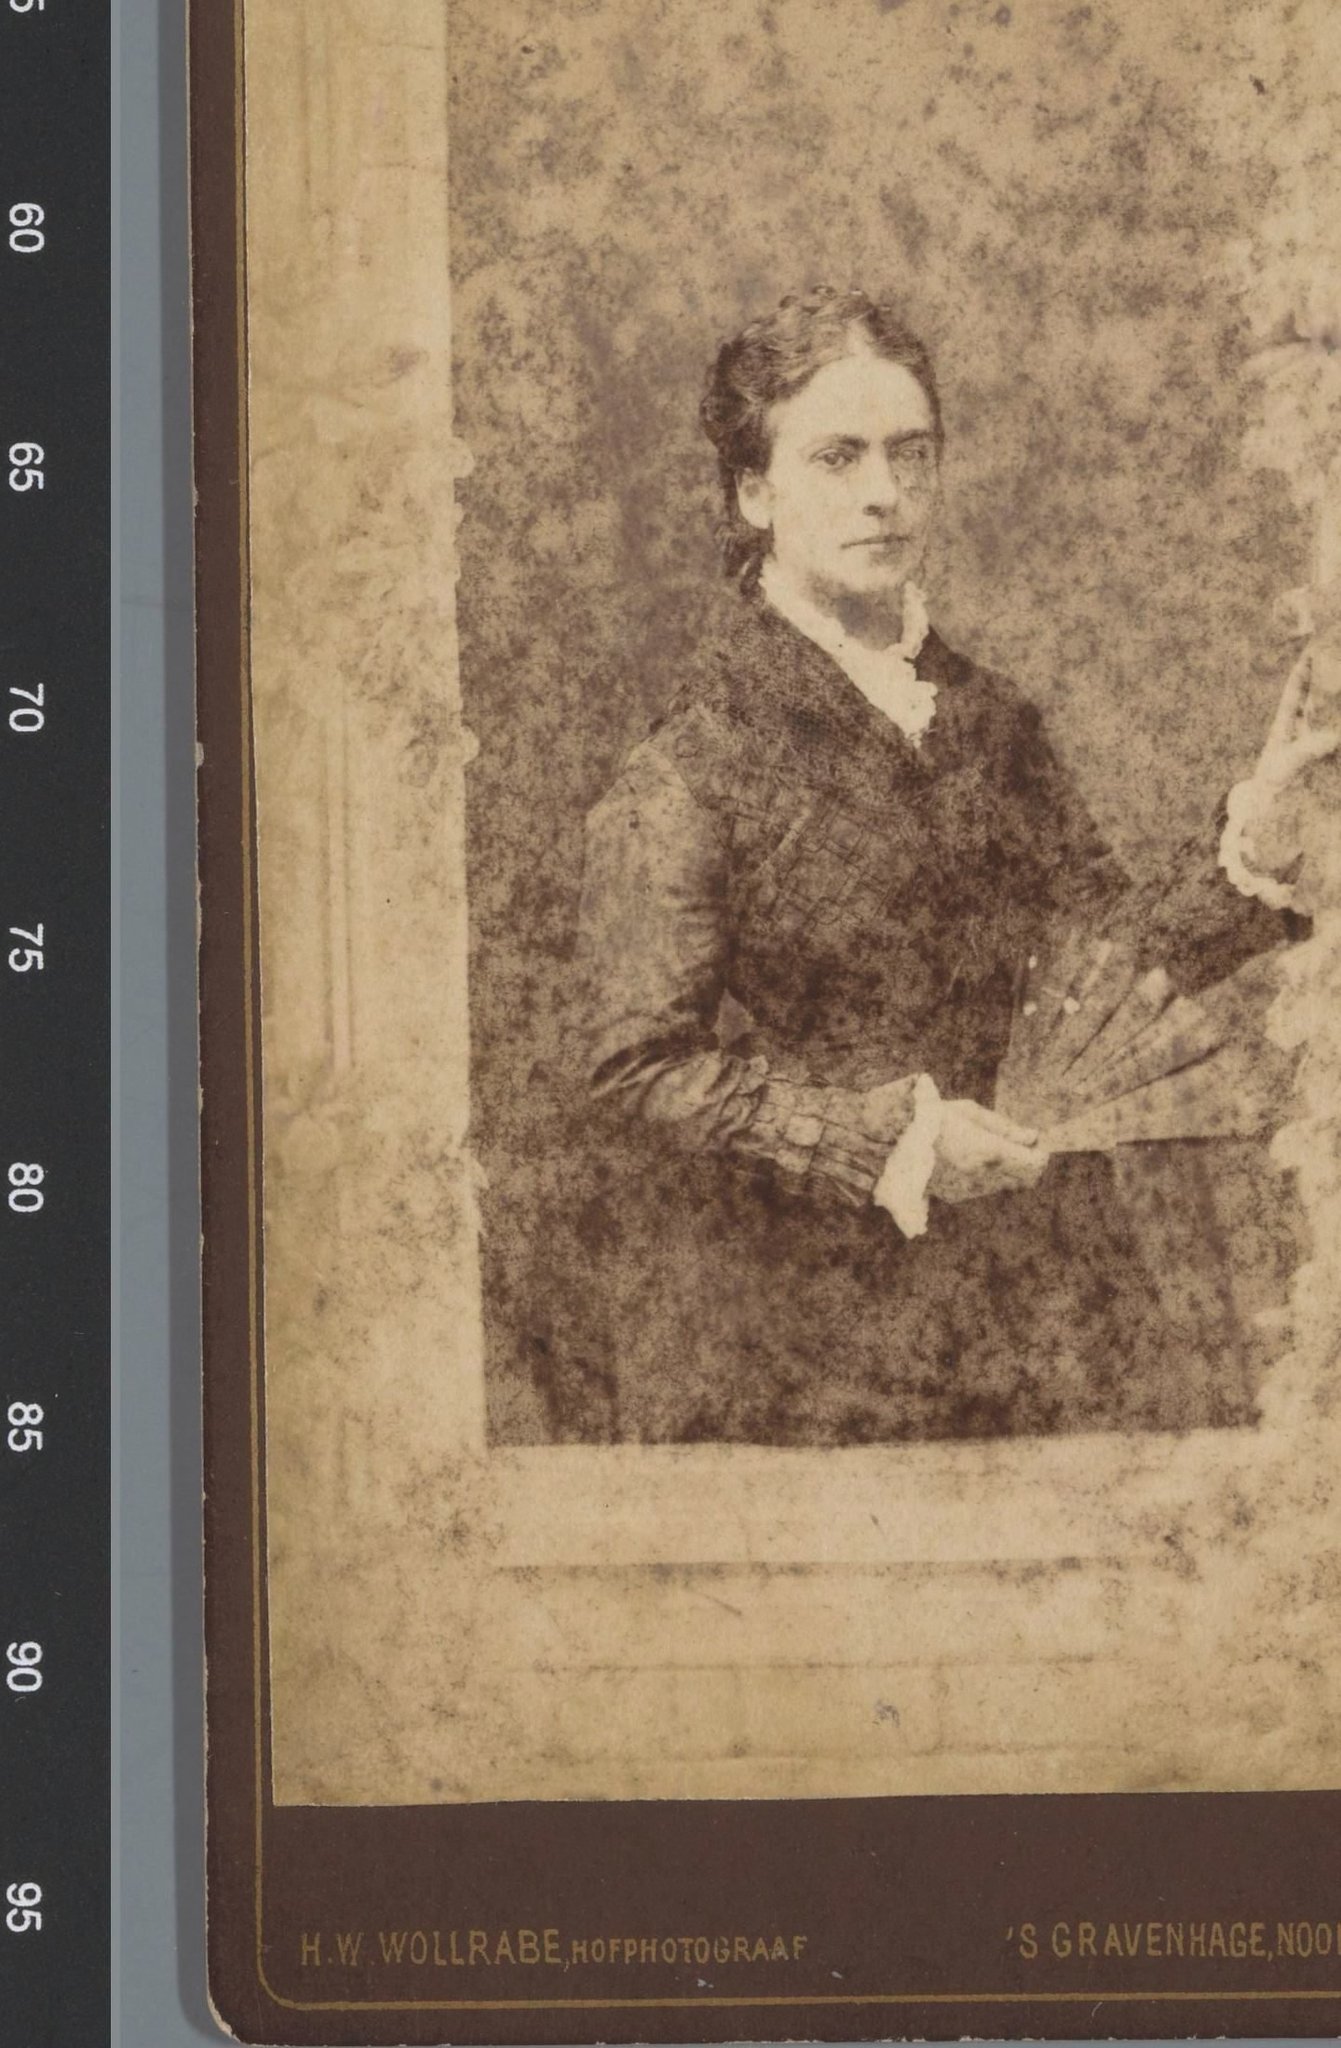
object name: photograph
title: Portret van een onbekende vrouw met waaier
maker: heinrich wilhelm wollrabe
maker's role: fotograaf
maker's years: 1843-1928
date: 1877-1910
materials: cardboard, paper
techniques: albumen print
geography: the hague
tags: adult woman, fan, anonymous historical person portrayed, the hague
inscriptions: inscription: ‘H.W. Wollrabe/ Hofphotograaf van Z.M. den Koning./ 96. Noordeinde 96./ 's Gravenhage./ Portretten tot in levensgrootte/ Photographien van Gebouwen/ en Schildereijen./ Onvergankelijke vergrootingen/ naar elk portret./ Voor nabestelling wordt de origineele plaat bewaard.’, inscription: ‘H.W. Wollrabe, Hofphotograaf 's Gravenhage, Noordeinde 96.’